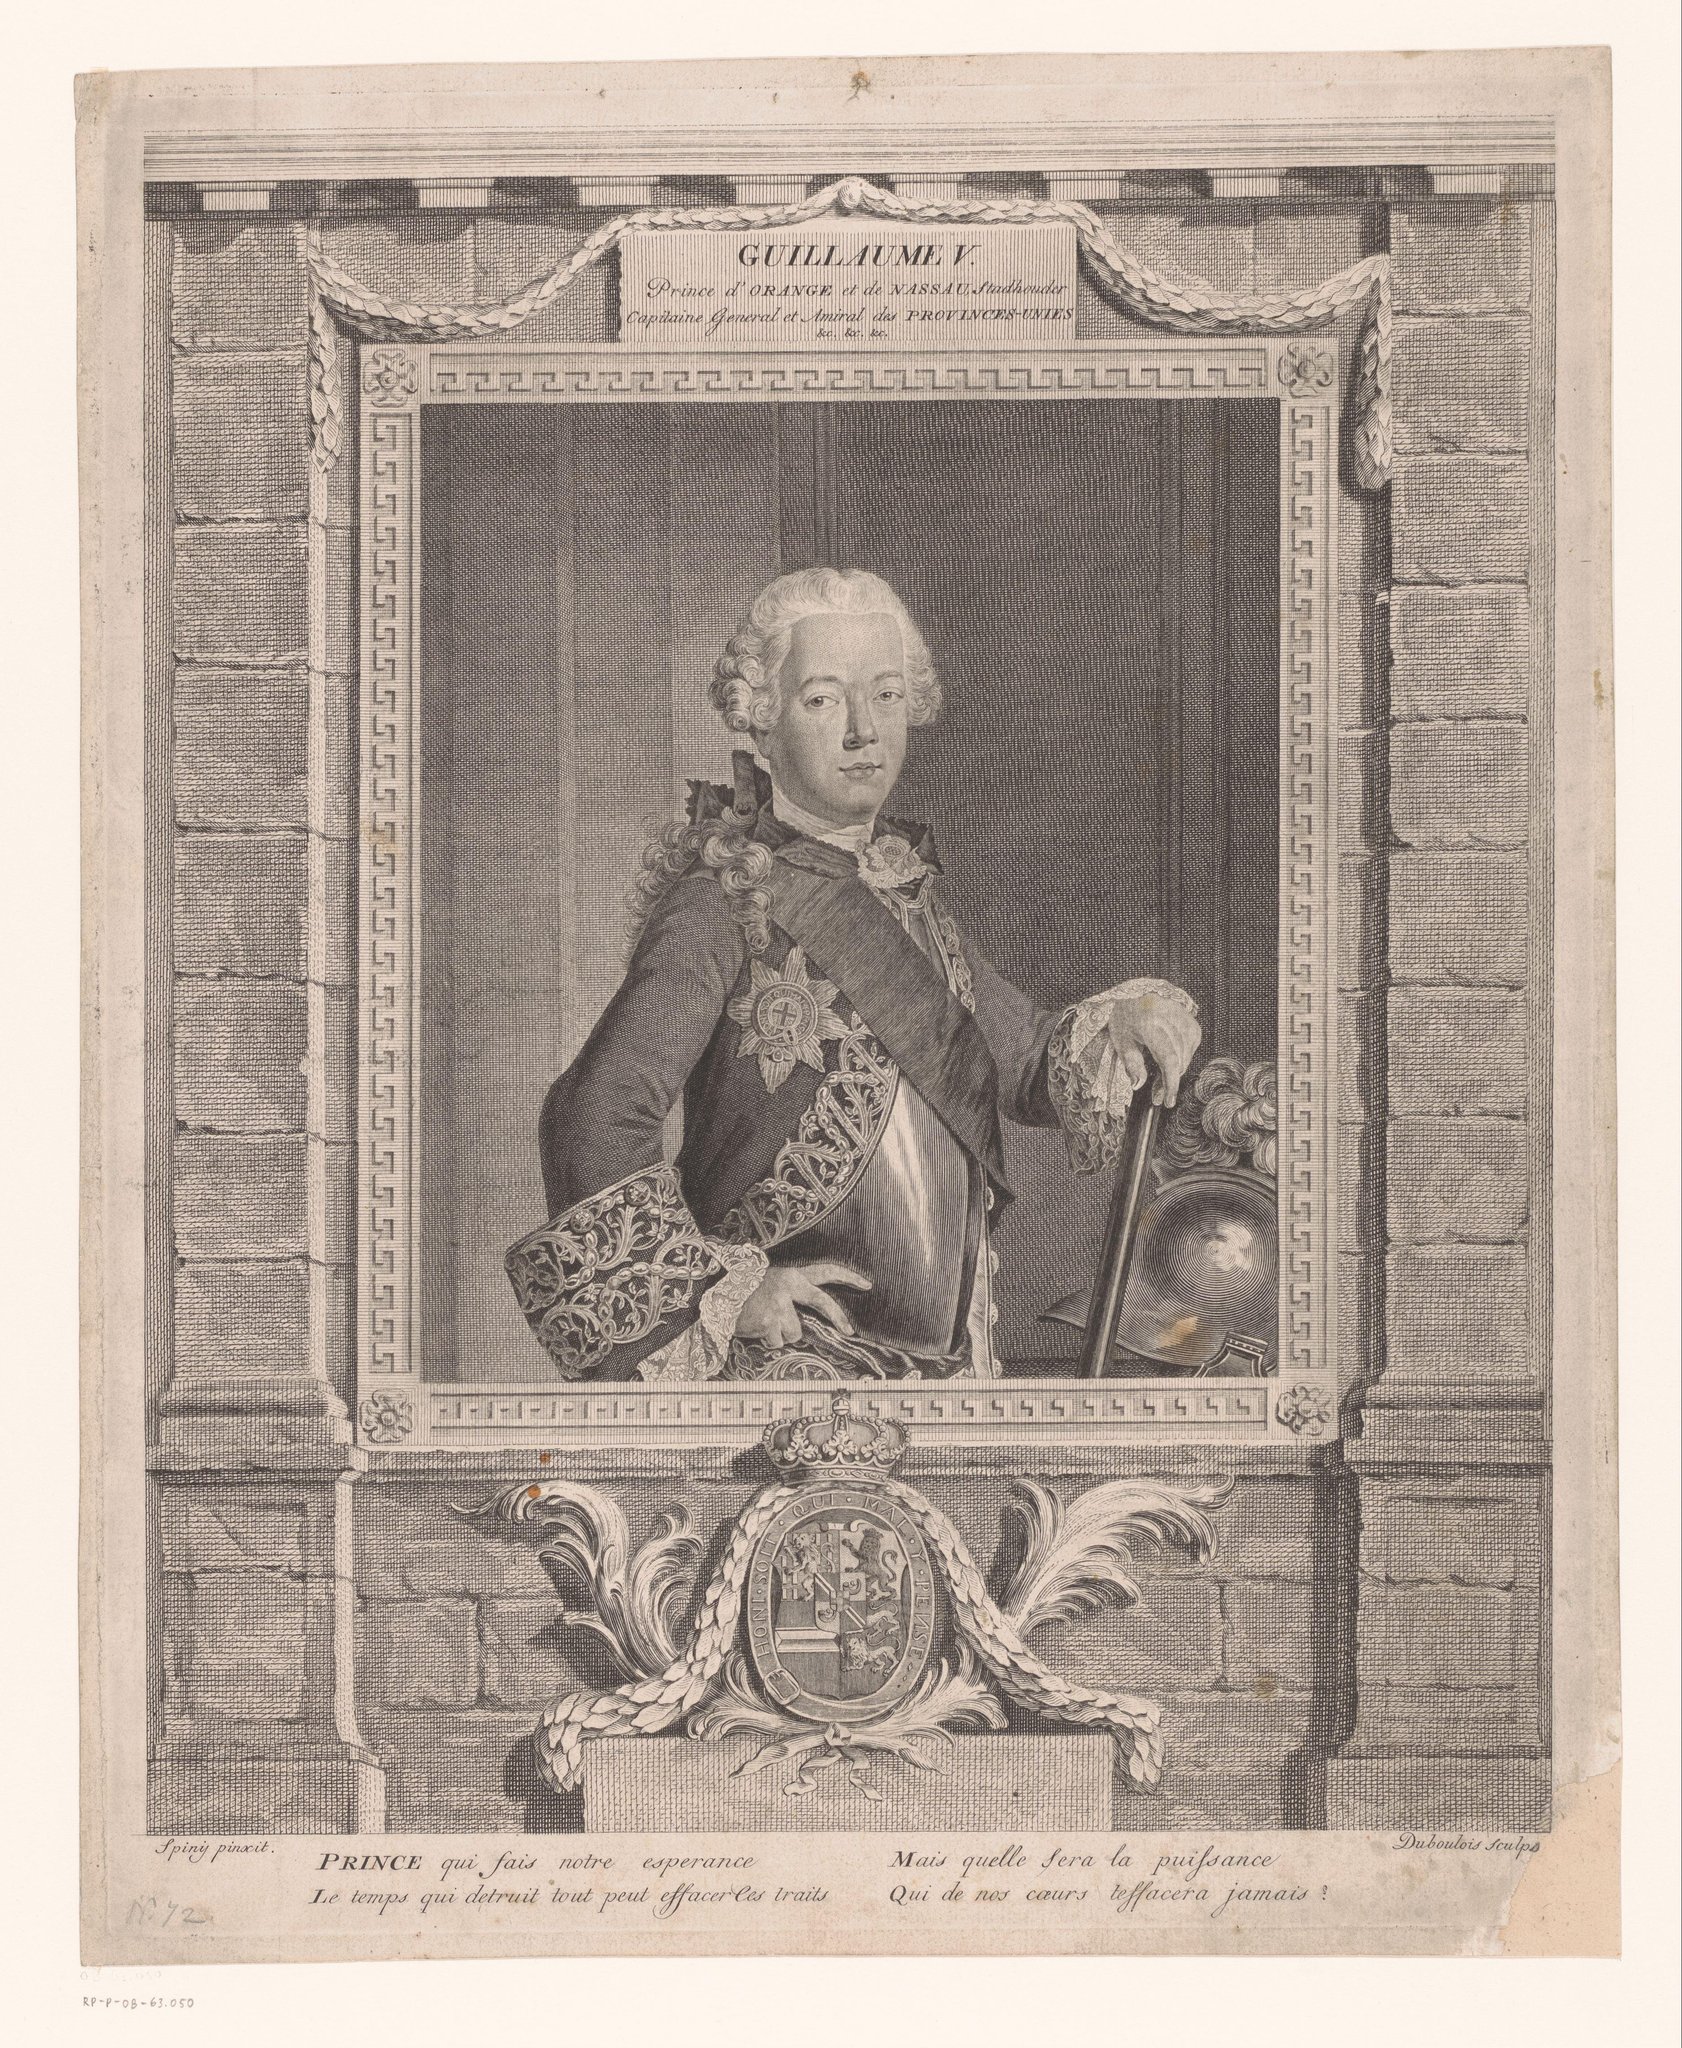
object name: print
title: Portret van Willem V, prins van Oranje en Nassau in een lijst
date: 1766-1769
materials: paper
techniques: engraving, etching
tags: the hague, william v (prince of orange), historical persons, ruler, sovereign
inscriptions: collector's mark: Lugt 2228